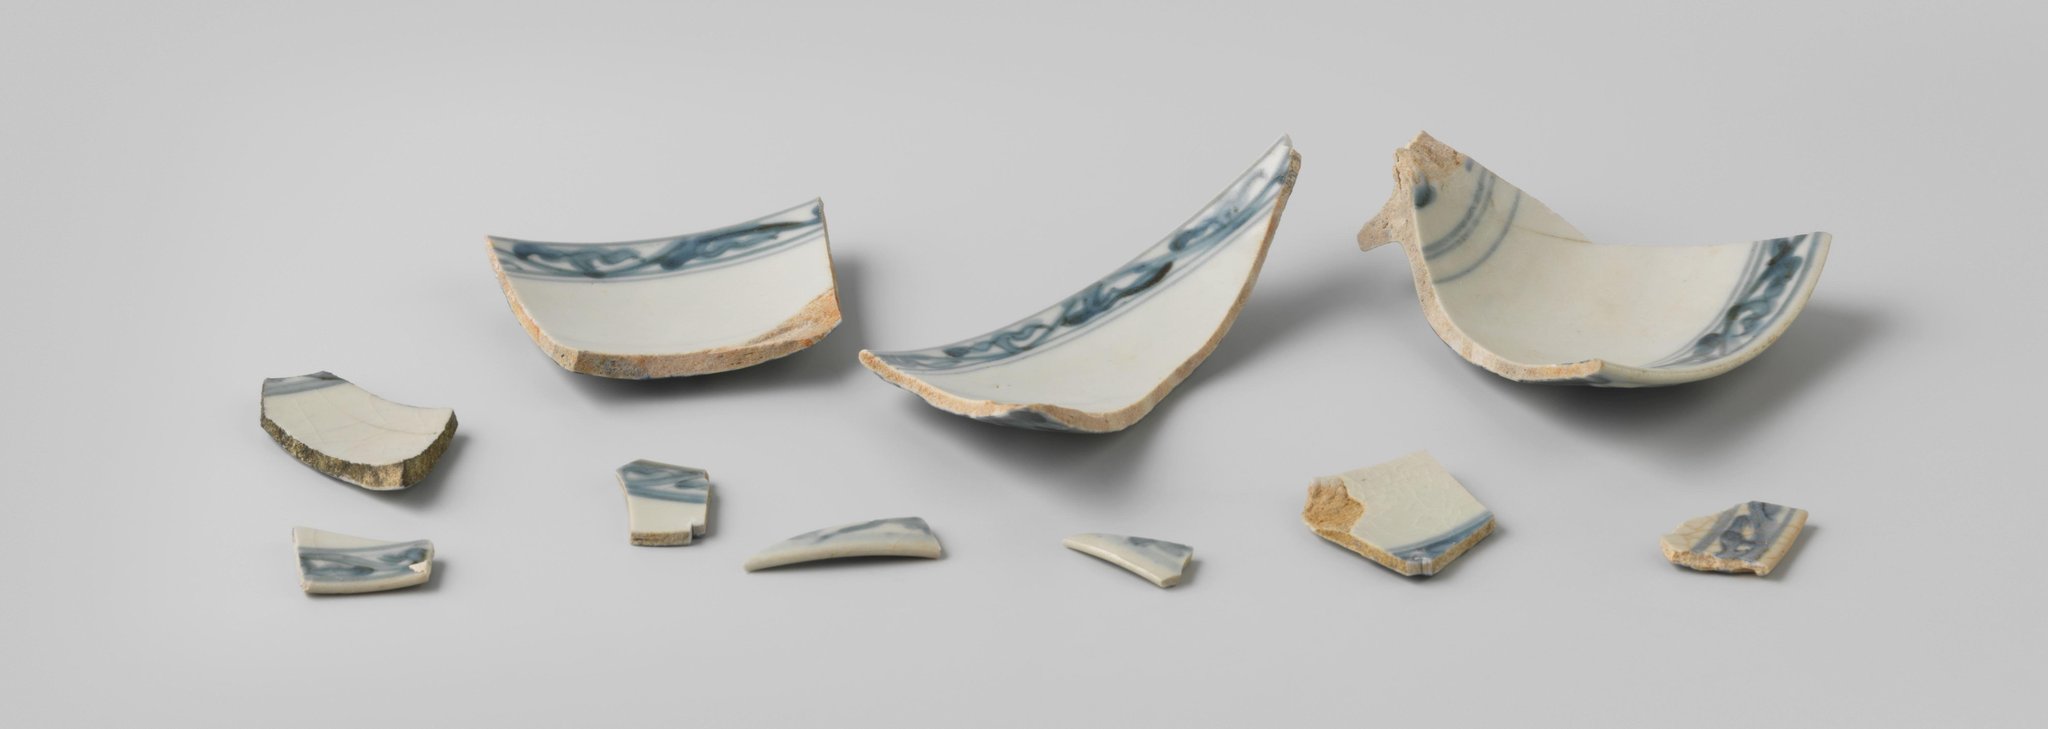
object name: sherd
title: Scherven van een bord uit V.O.C.-schip de 'Witte Leeuw'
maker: Anonymous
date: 1613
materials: porcelain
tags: verenigde oostindische compagnie, sint-helena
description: Scherven van een bord uit V.O.C.-schip de 'Witte Leeuw'.